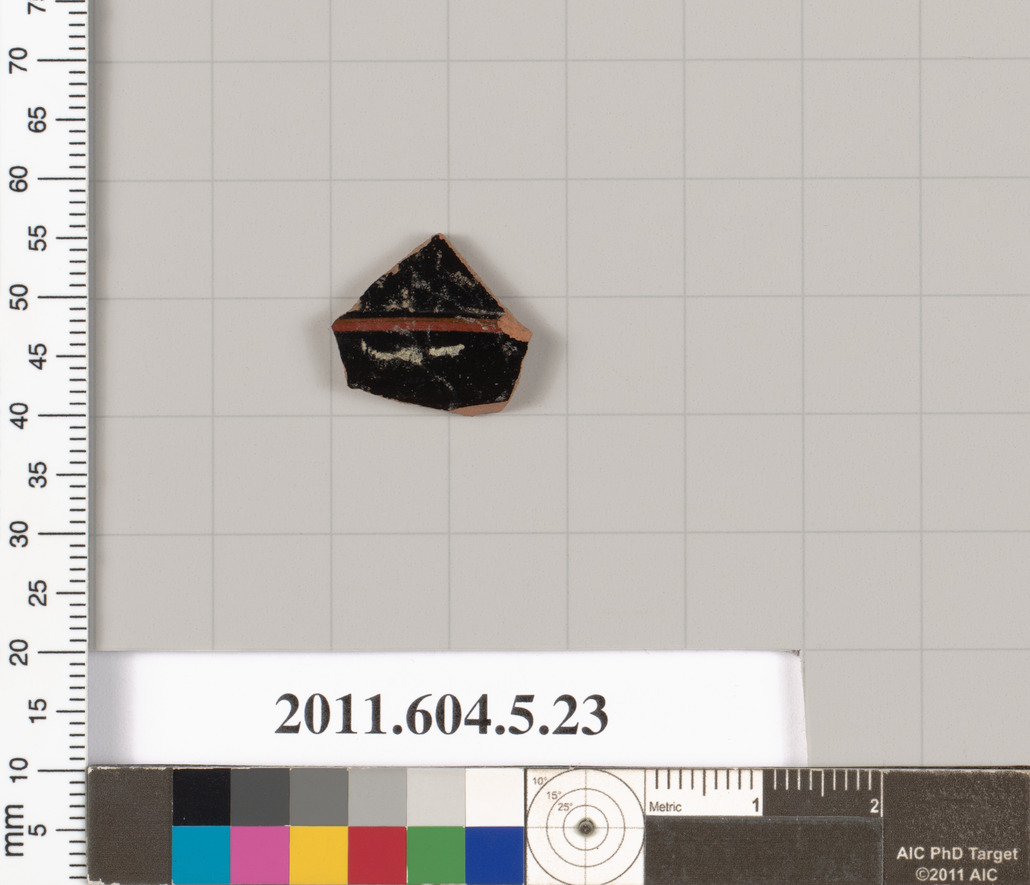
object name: kylix fragment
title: Terracotta fragment of a kylix (drinking cup)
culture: greek, attic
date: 475-451 BCE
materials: terracotta